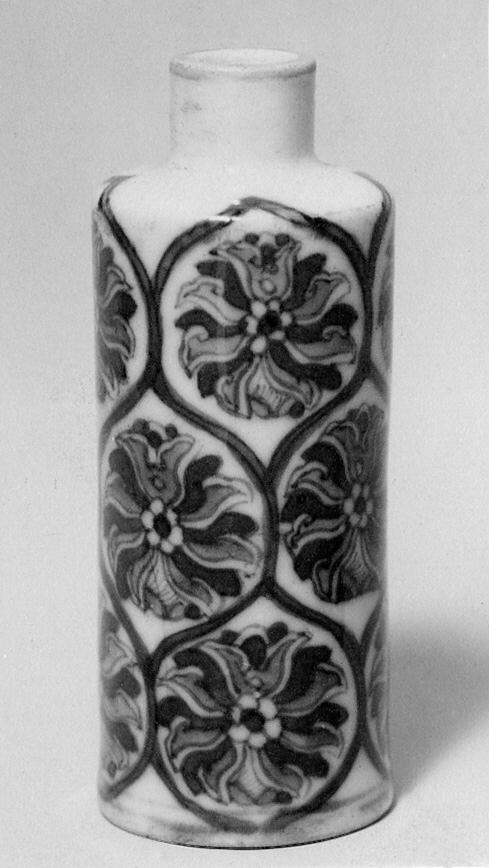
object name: snuff bottle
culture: chinese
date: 1723-1735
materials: porcelain